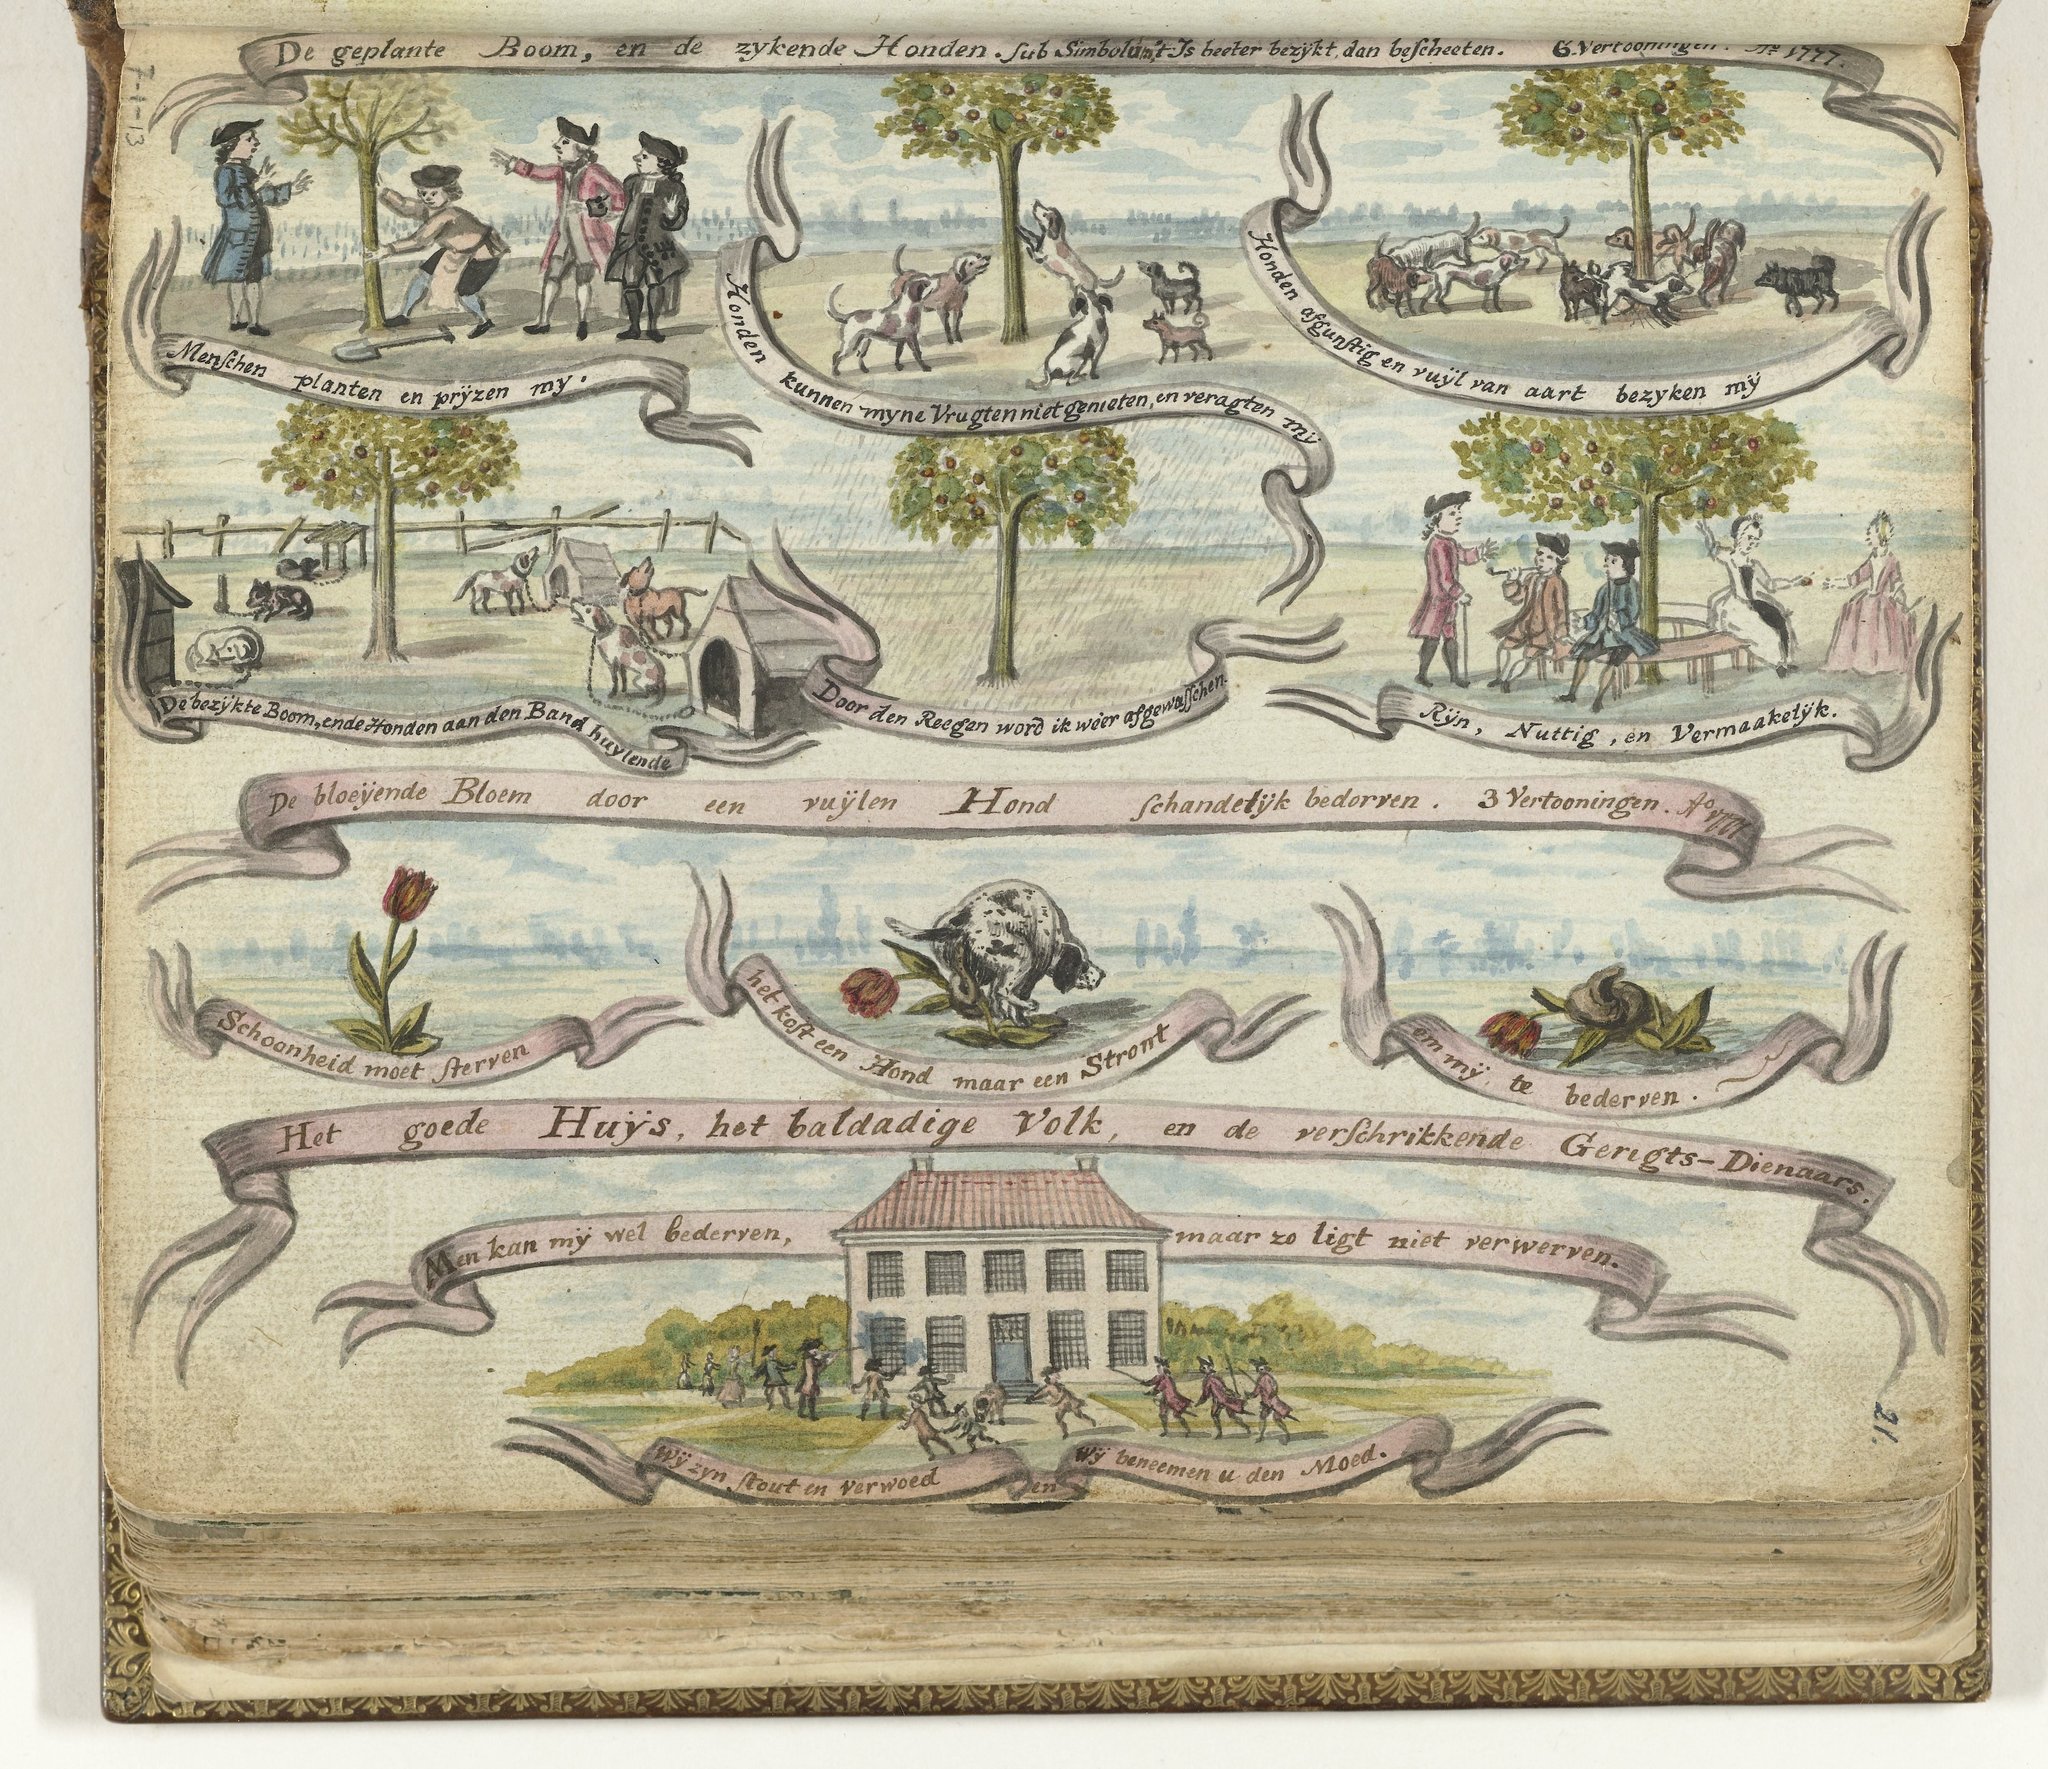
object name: drawing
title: Allegorie op de samenleving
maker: jan brandes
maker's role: draughtsman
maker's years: 1743-1808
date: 1777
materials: paper, pencil, watercolor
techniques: brush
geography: doetinchem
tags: dog (+ animal excreting), trees (+ plants used symbolically), netherlands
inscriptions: date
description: Kleurtekening. Een serie van 6 voorstellingen over de (vrijheids)boom. Een serie van 3 voorstellingen over een bloem die wordt bescheten. En een voorstelling over het 'goede huis', 'baldadig volk' en de 'verschrikkende gerechtsdienaar'. Met opschrift. Onderdeel uit het schetsboek van Jan Brandes, dl. 1 (1808), p. 21.